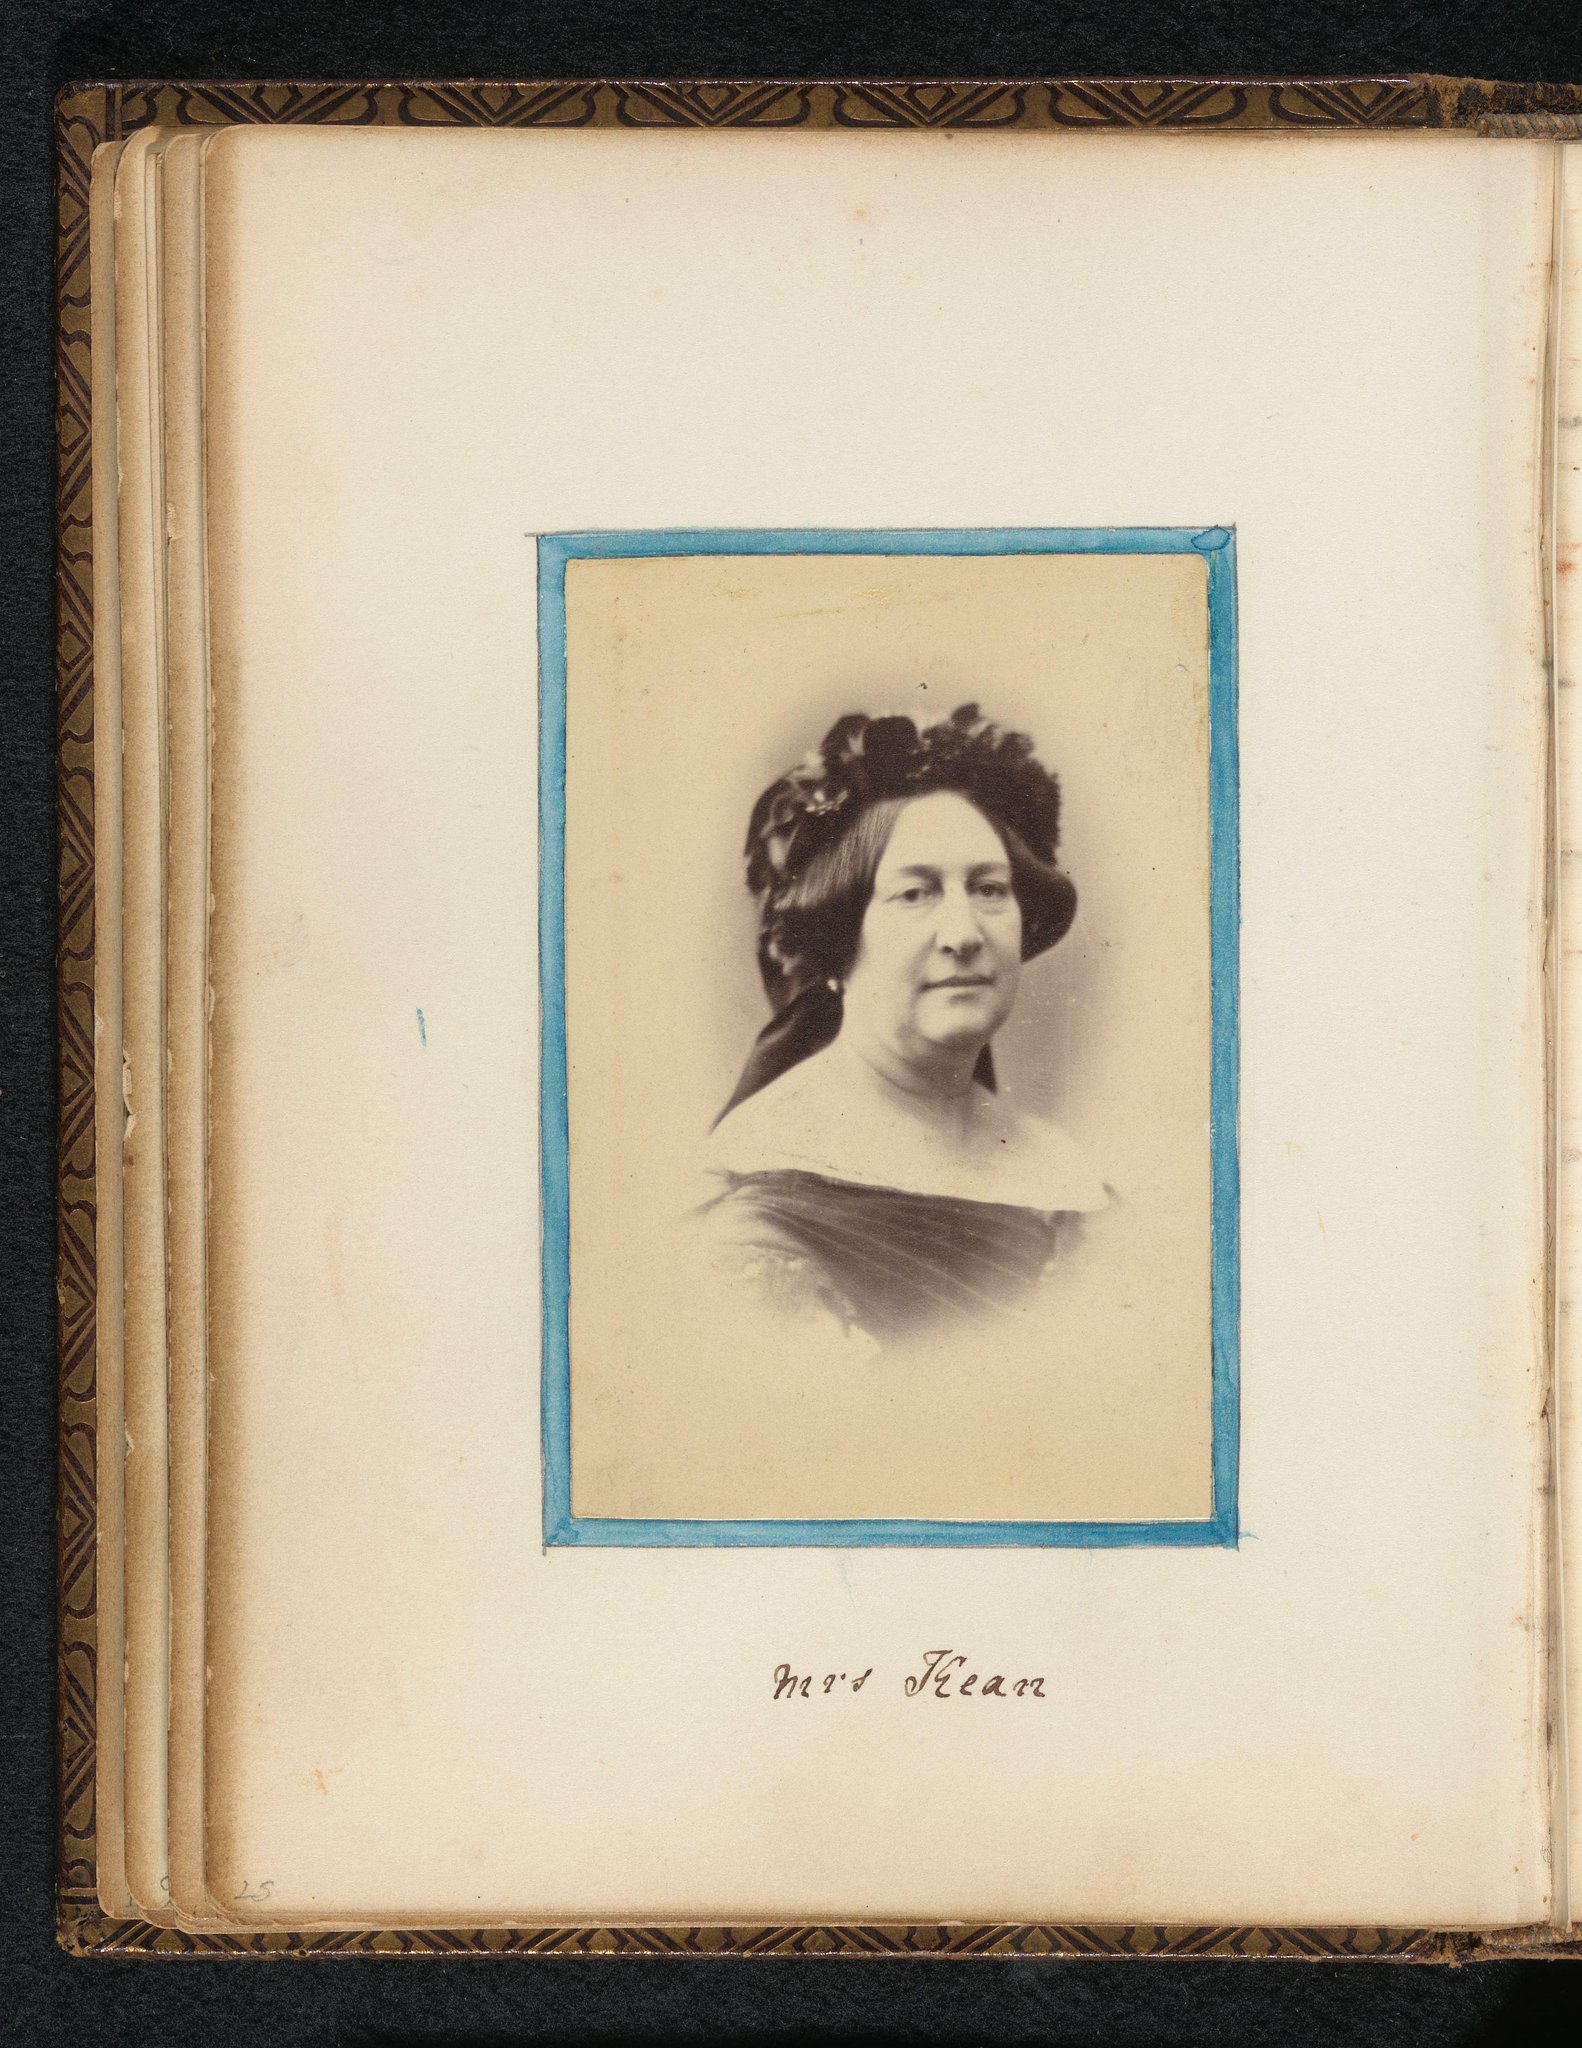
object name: album leaf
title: Portret van mevr. Kean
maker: Anonymous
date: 1865-1867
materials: cardboard, photographic support, watercolor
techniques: albumen print, aquarelle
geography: england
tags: historical persons - bb - woman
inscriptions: annotation: ‘mrs Kean’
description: Portret van mevr. Kean. Foto op albumblad in album met 68 foto's merendeels met geaquarelleerde randversieringen. Het zijn voornamelijk portretten op carte-de-visite formaat.